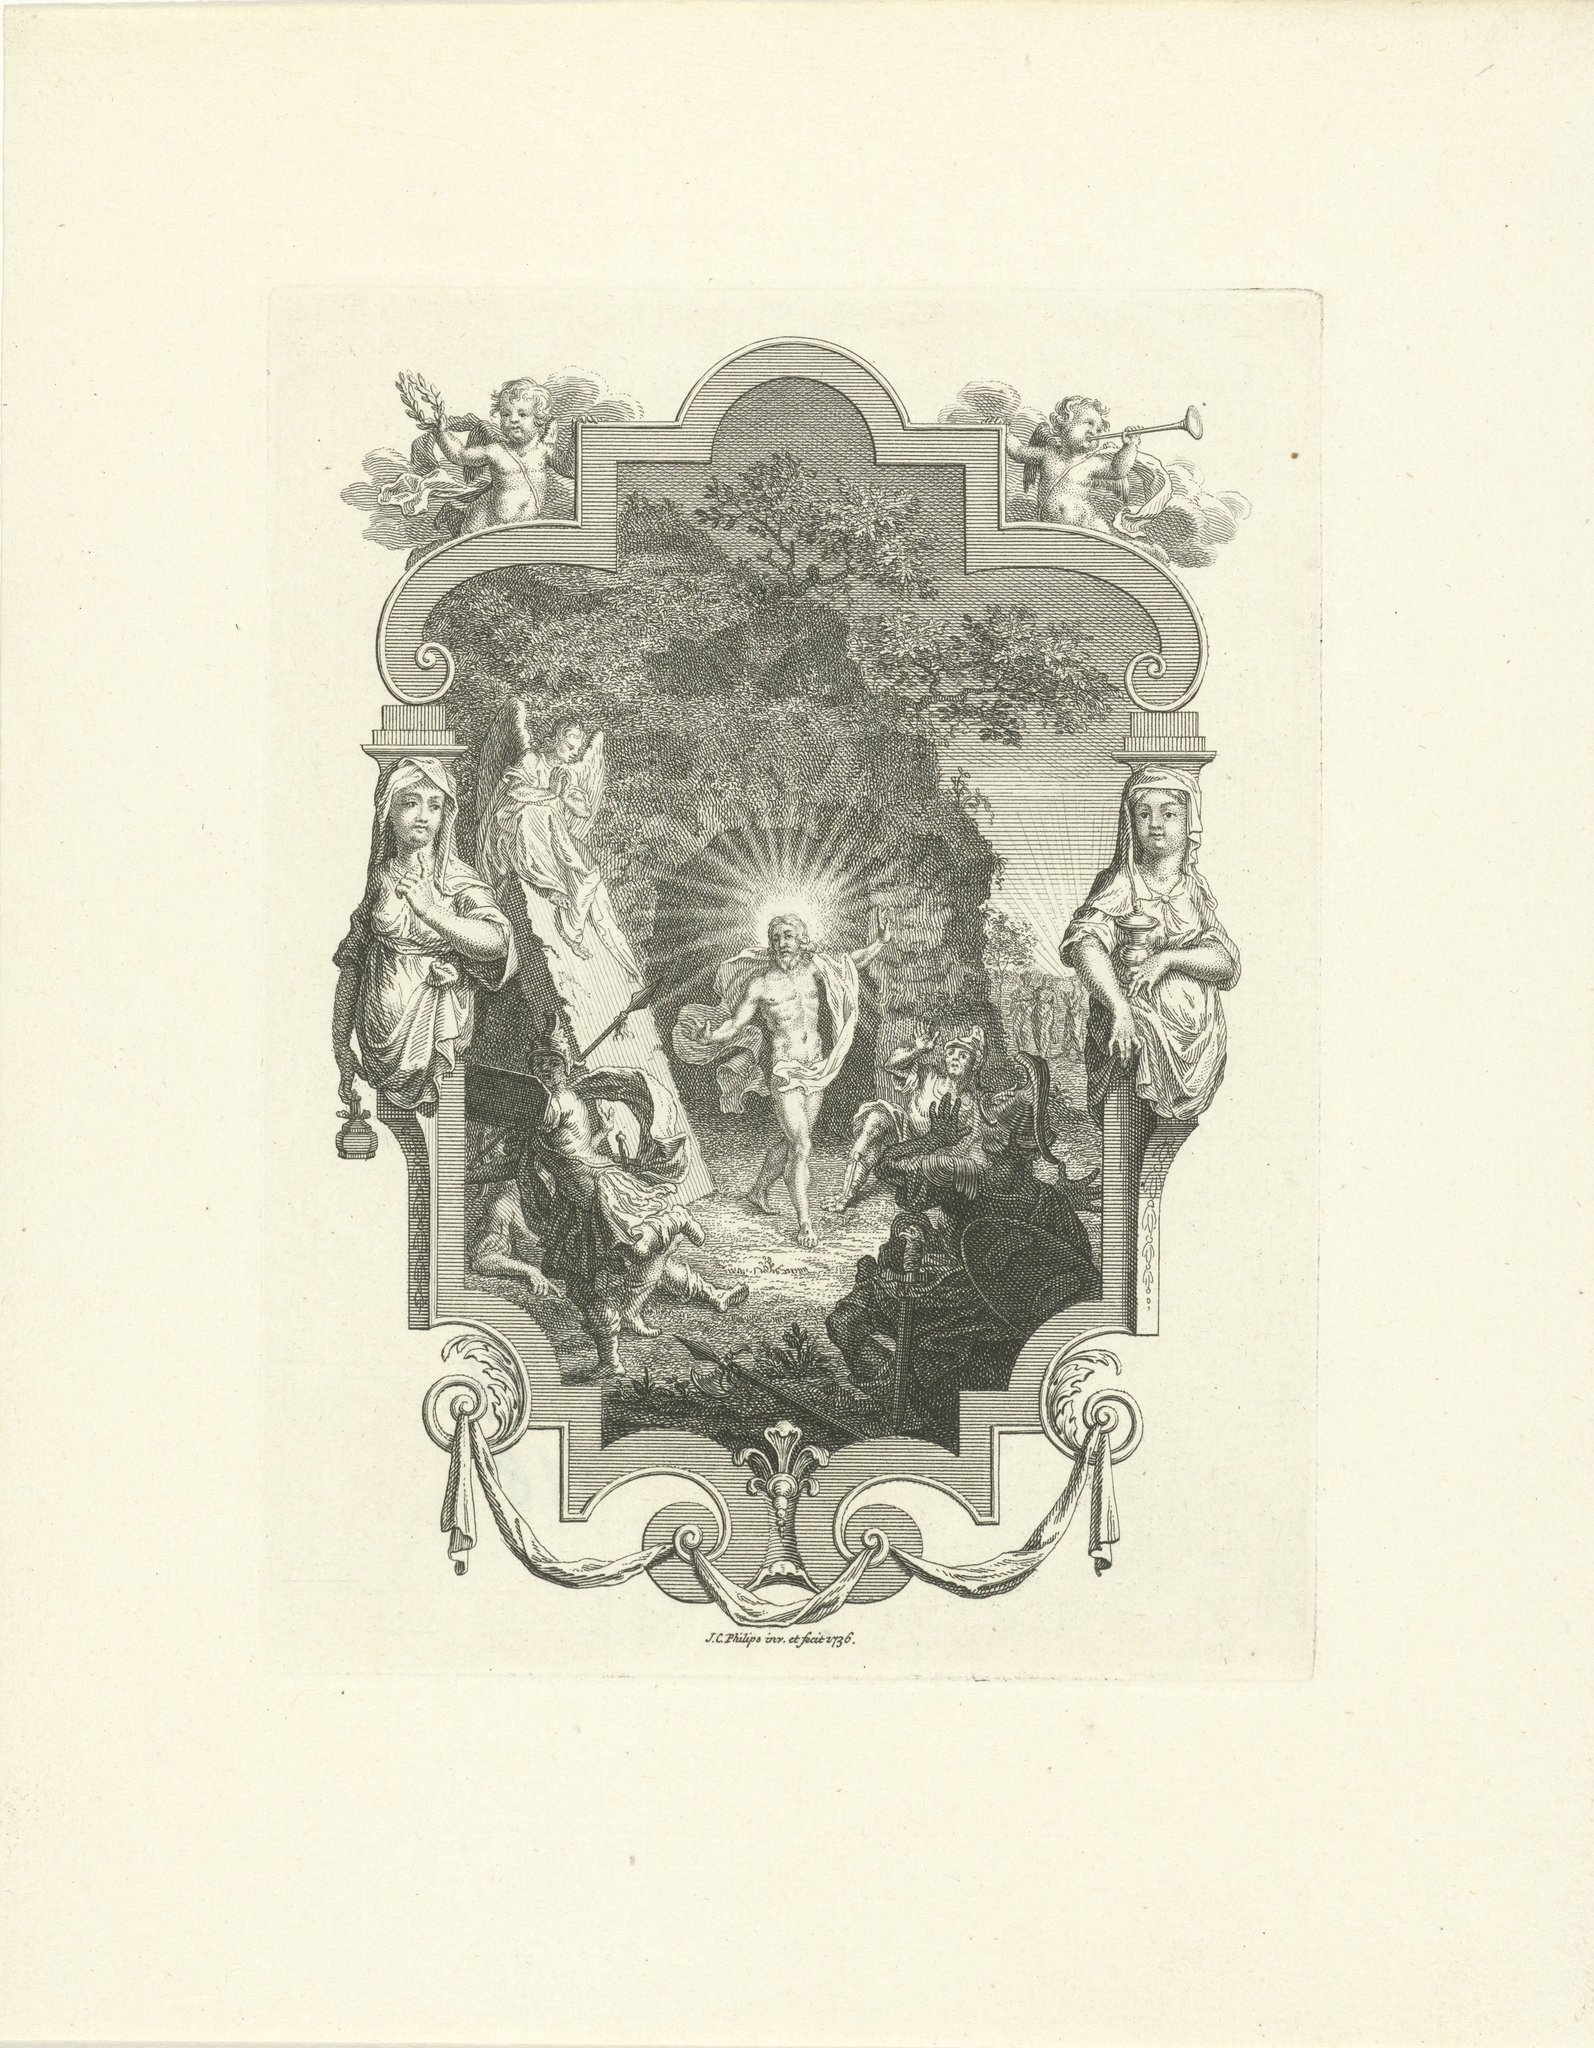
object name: print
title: Cartouche met de opstanding van Christus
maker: jan caspar philips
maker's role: draughtsman, print maker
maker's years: 1700-1775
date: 1736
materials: paper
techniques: engraving, etching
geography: amsterdam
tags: the holy women (the three maries) on their way to or at the tomb, to anoint christ's body, resurrection of christ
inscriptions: collector's mark: Lugt 2233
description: Christus verrijst uit zijn graf. De soldaten die rondom het graf liggen schrikken wakker en vluchten. Rechts op de achtergrond de aankomst van de drie heilige vrouwen bij het graf. De voorstelling is gevat in een cartouche.